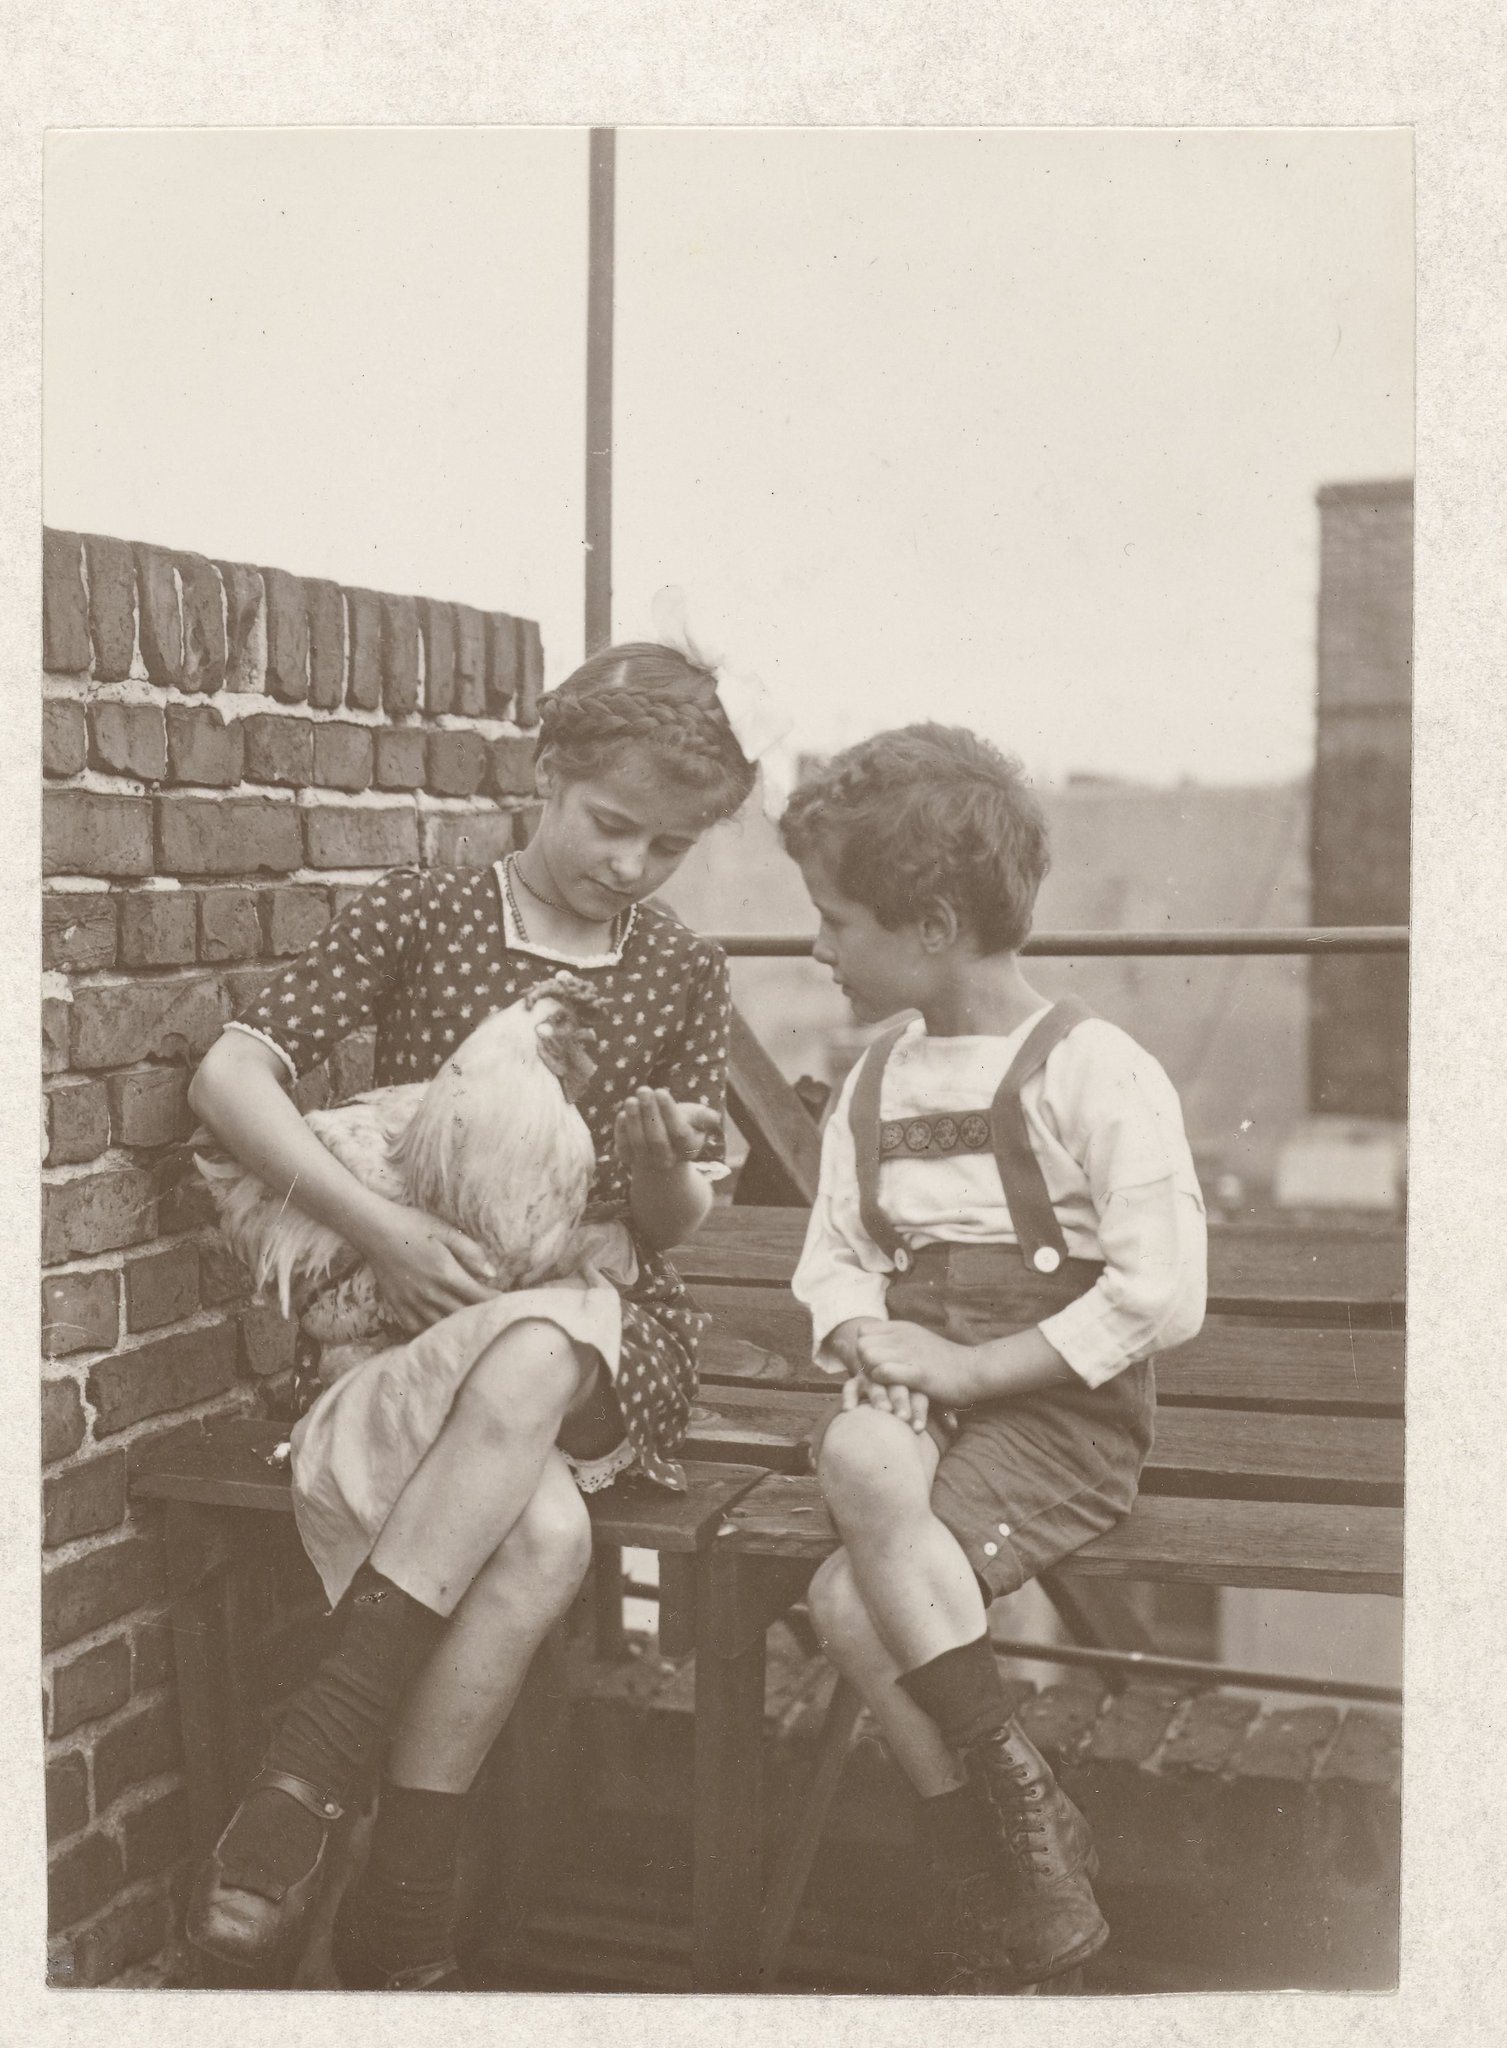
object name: photograph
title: Marba en Eckart Titzenthaler, kinderen van de fotograaf, met haan op het dakterras van het woonhuis in de Friedrichstrasse, Berlijn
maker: waldemar titzenthaler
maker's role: fotograaf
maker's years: 1869-1937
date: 1918-1920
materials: paper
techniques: gelatin silver print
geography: berlin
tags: berlin, engineer, boy (child between toddler and youth), girl (child between toddler and youth), fowl (cock, hen, chicken, etc.)